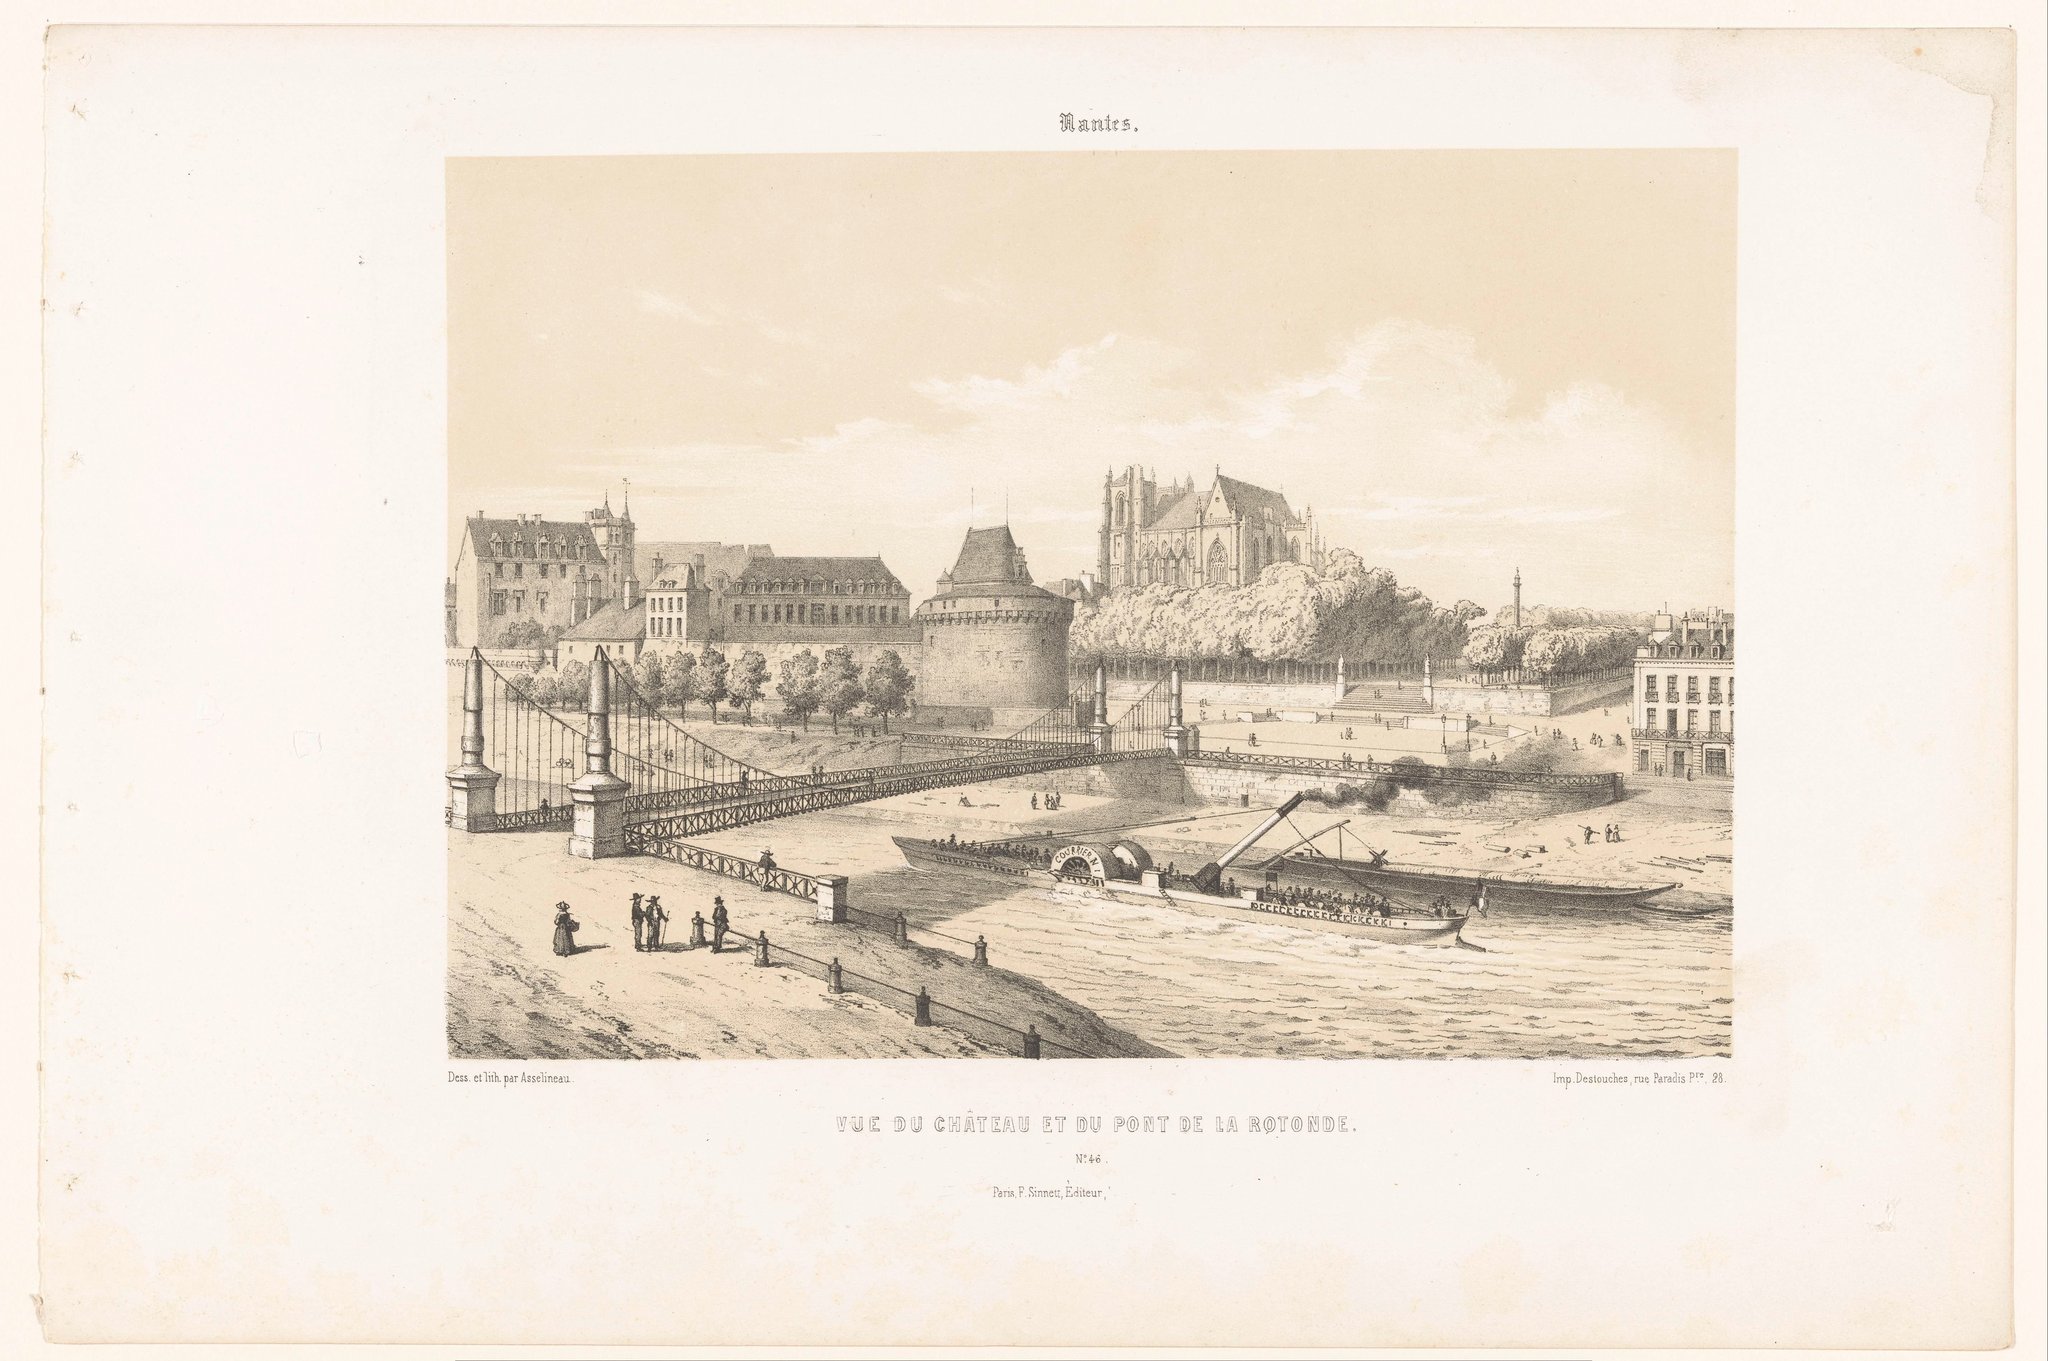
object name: print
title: Nantes. Vue du château et du pont de la Rotonde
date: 1853-1856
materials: paper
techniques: tone lithography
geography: rouen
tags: castle, ships (in general), bridge in city across river, canal, etc.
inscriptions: collector's mark: Lugt 2228